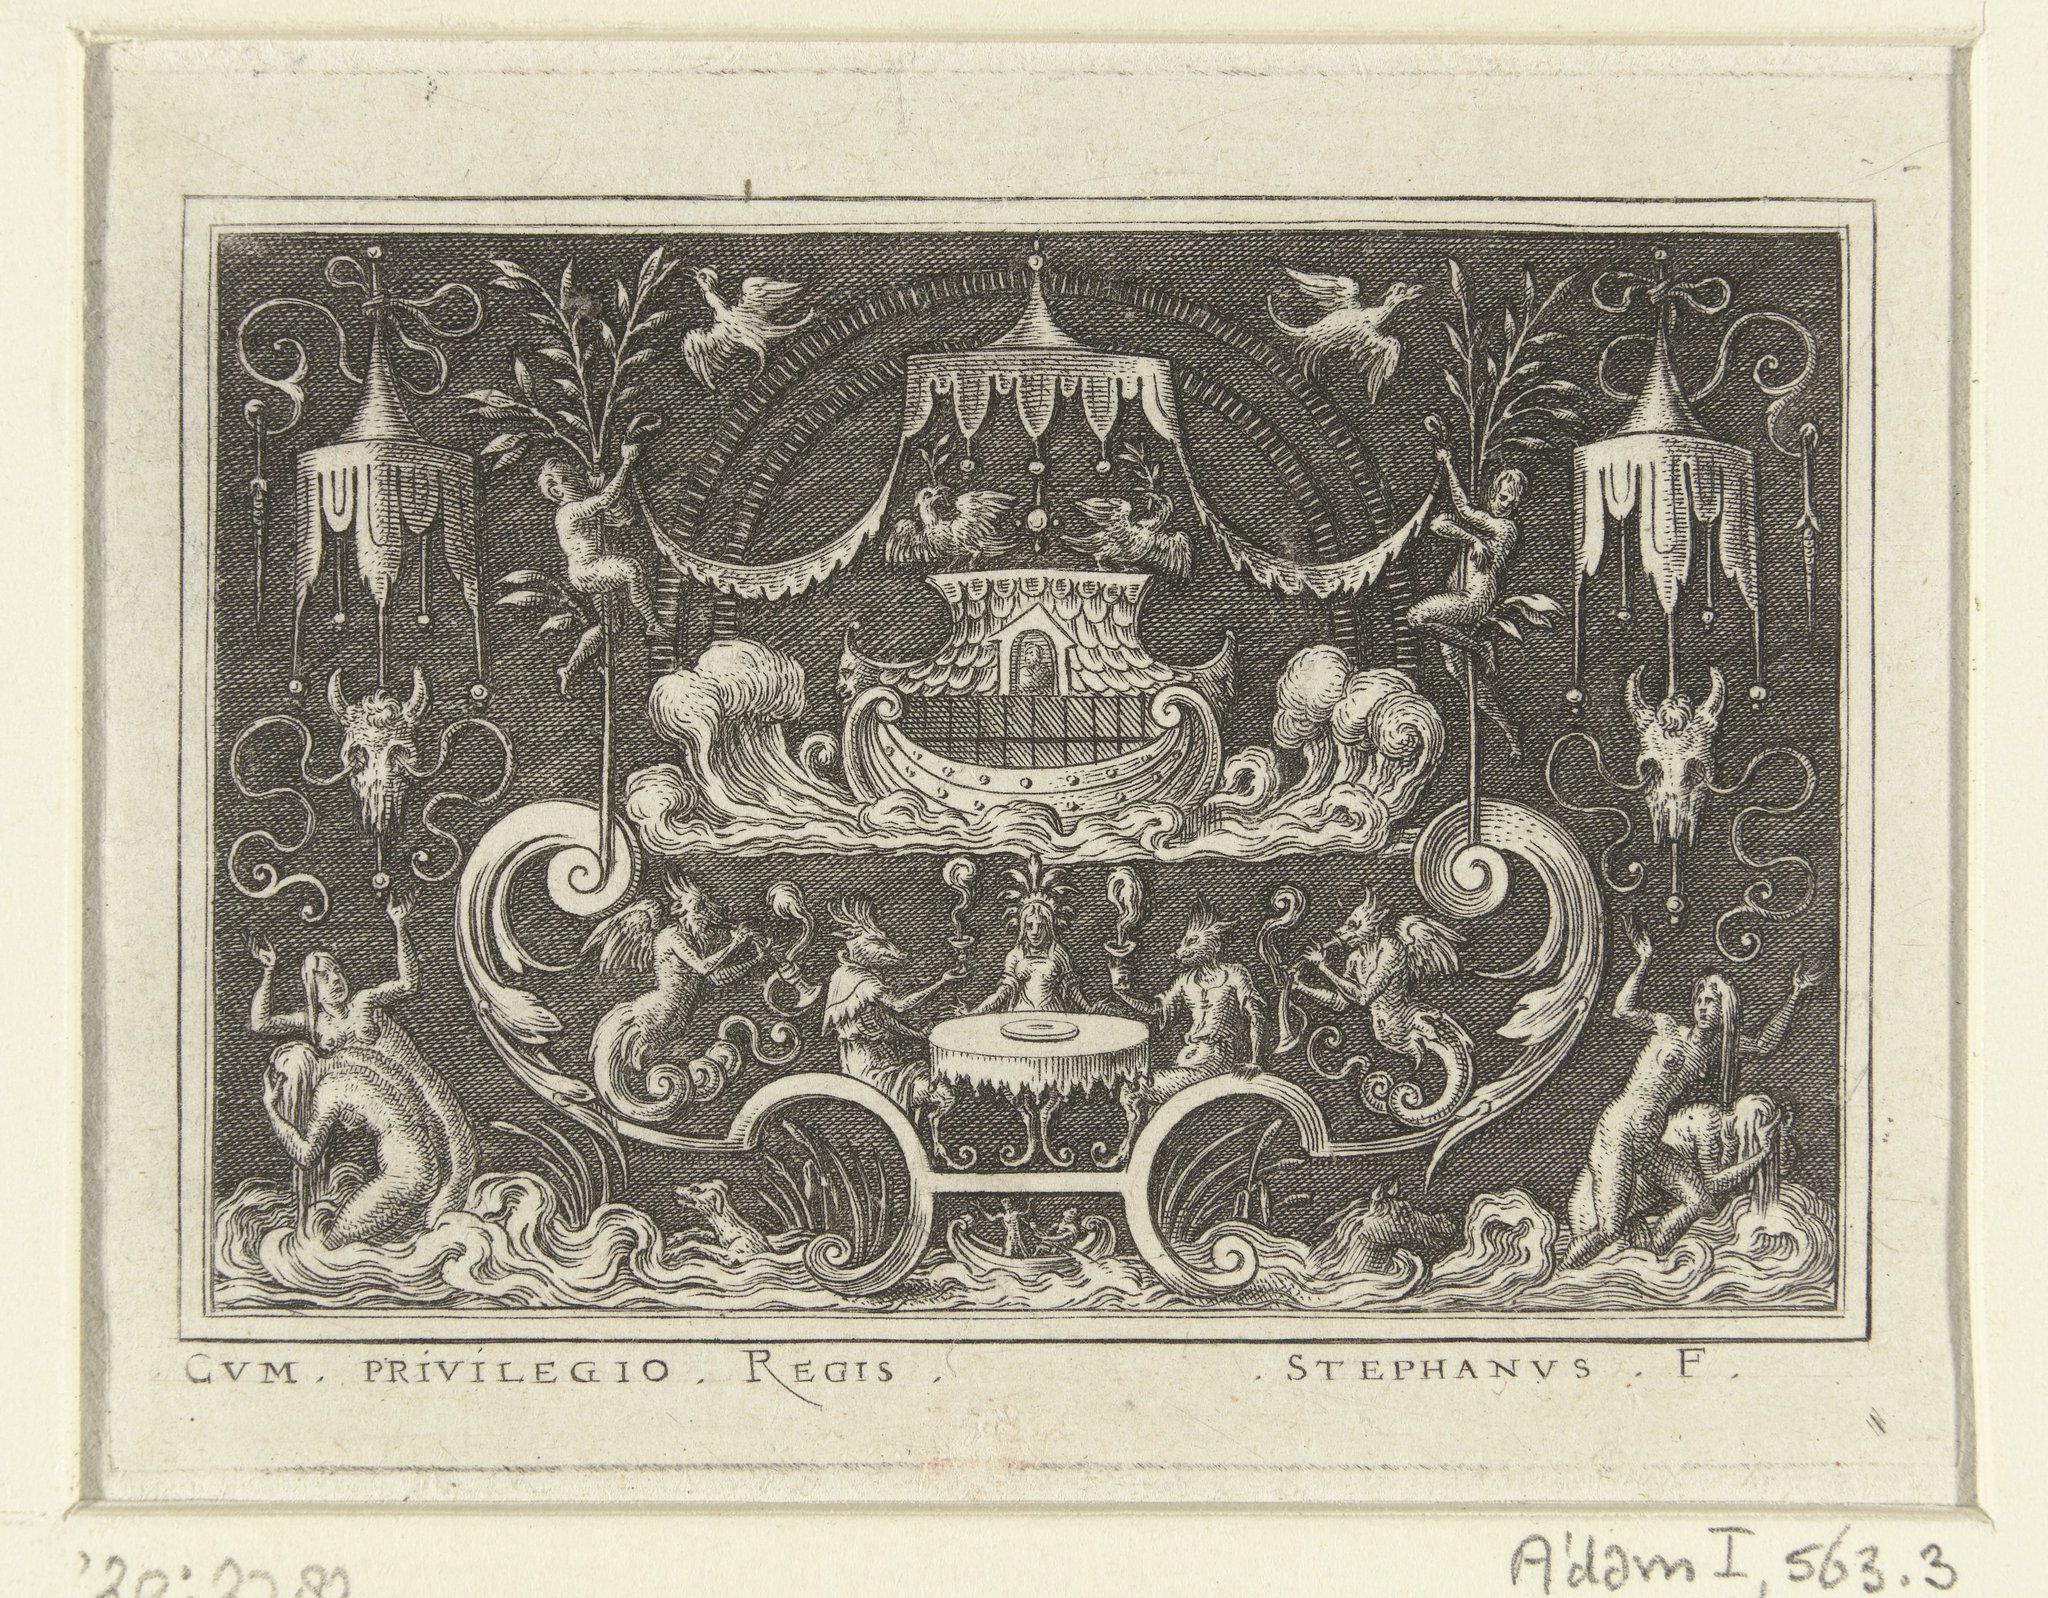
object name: print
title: De zondvloed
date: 1528-1583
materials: paper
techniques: engraving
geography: france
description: In het midden drijft de Ark van Noach onder een baldakijn. Uit serie van 6 bladen.